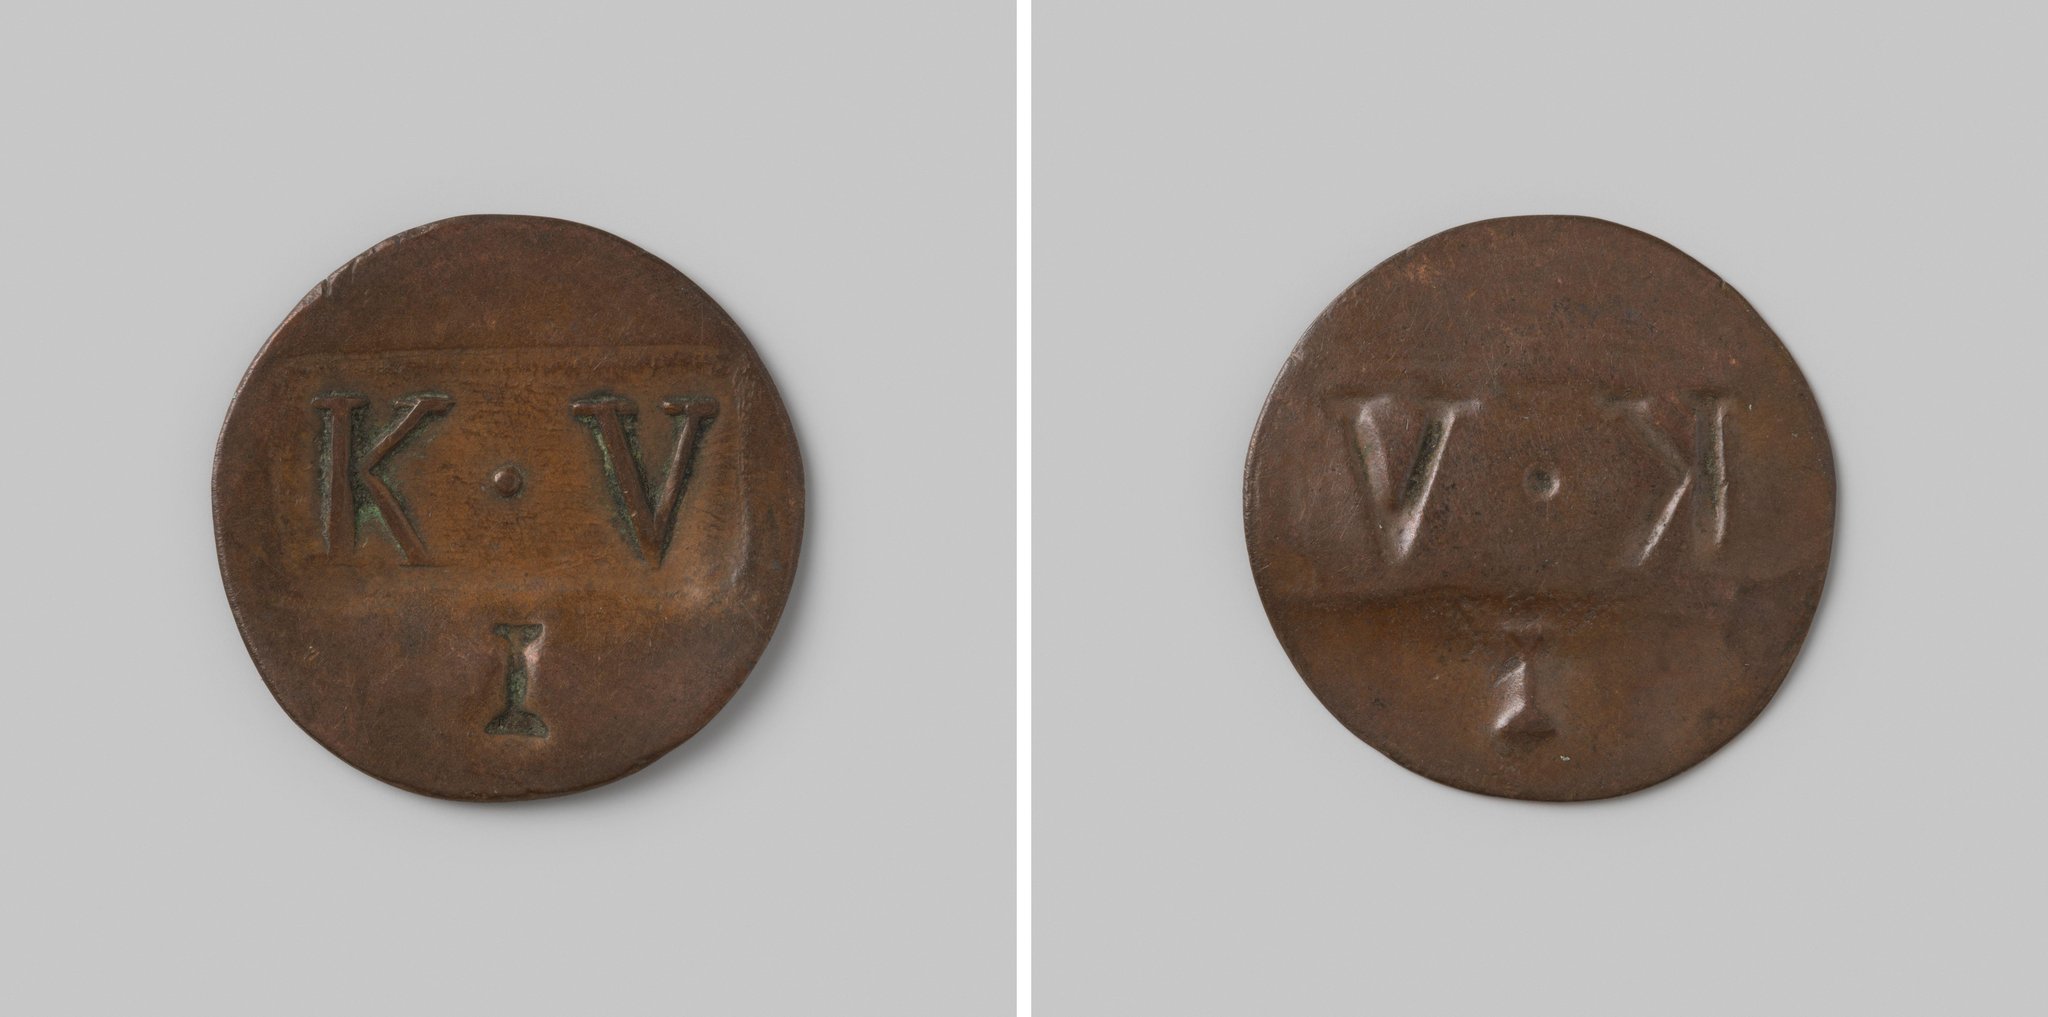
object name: history medal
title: Betaalpenning van 1 cent van de Kolonie Veenhuizen van de Maatschappij van Weldadigheid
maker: Anonymous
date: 1825-1830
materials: copper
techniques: printing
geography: veenhuizen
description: Rond plaatje koper met ingeperst twee letters (opwaarts) en het cijfer I (inwaarts).